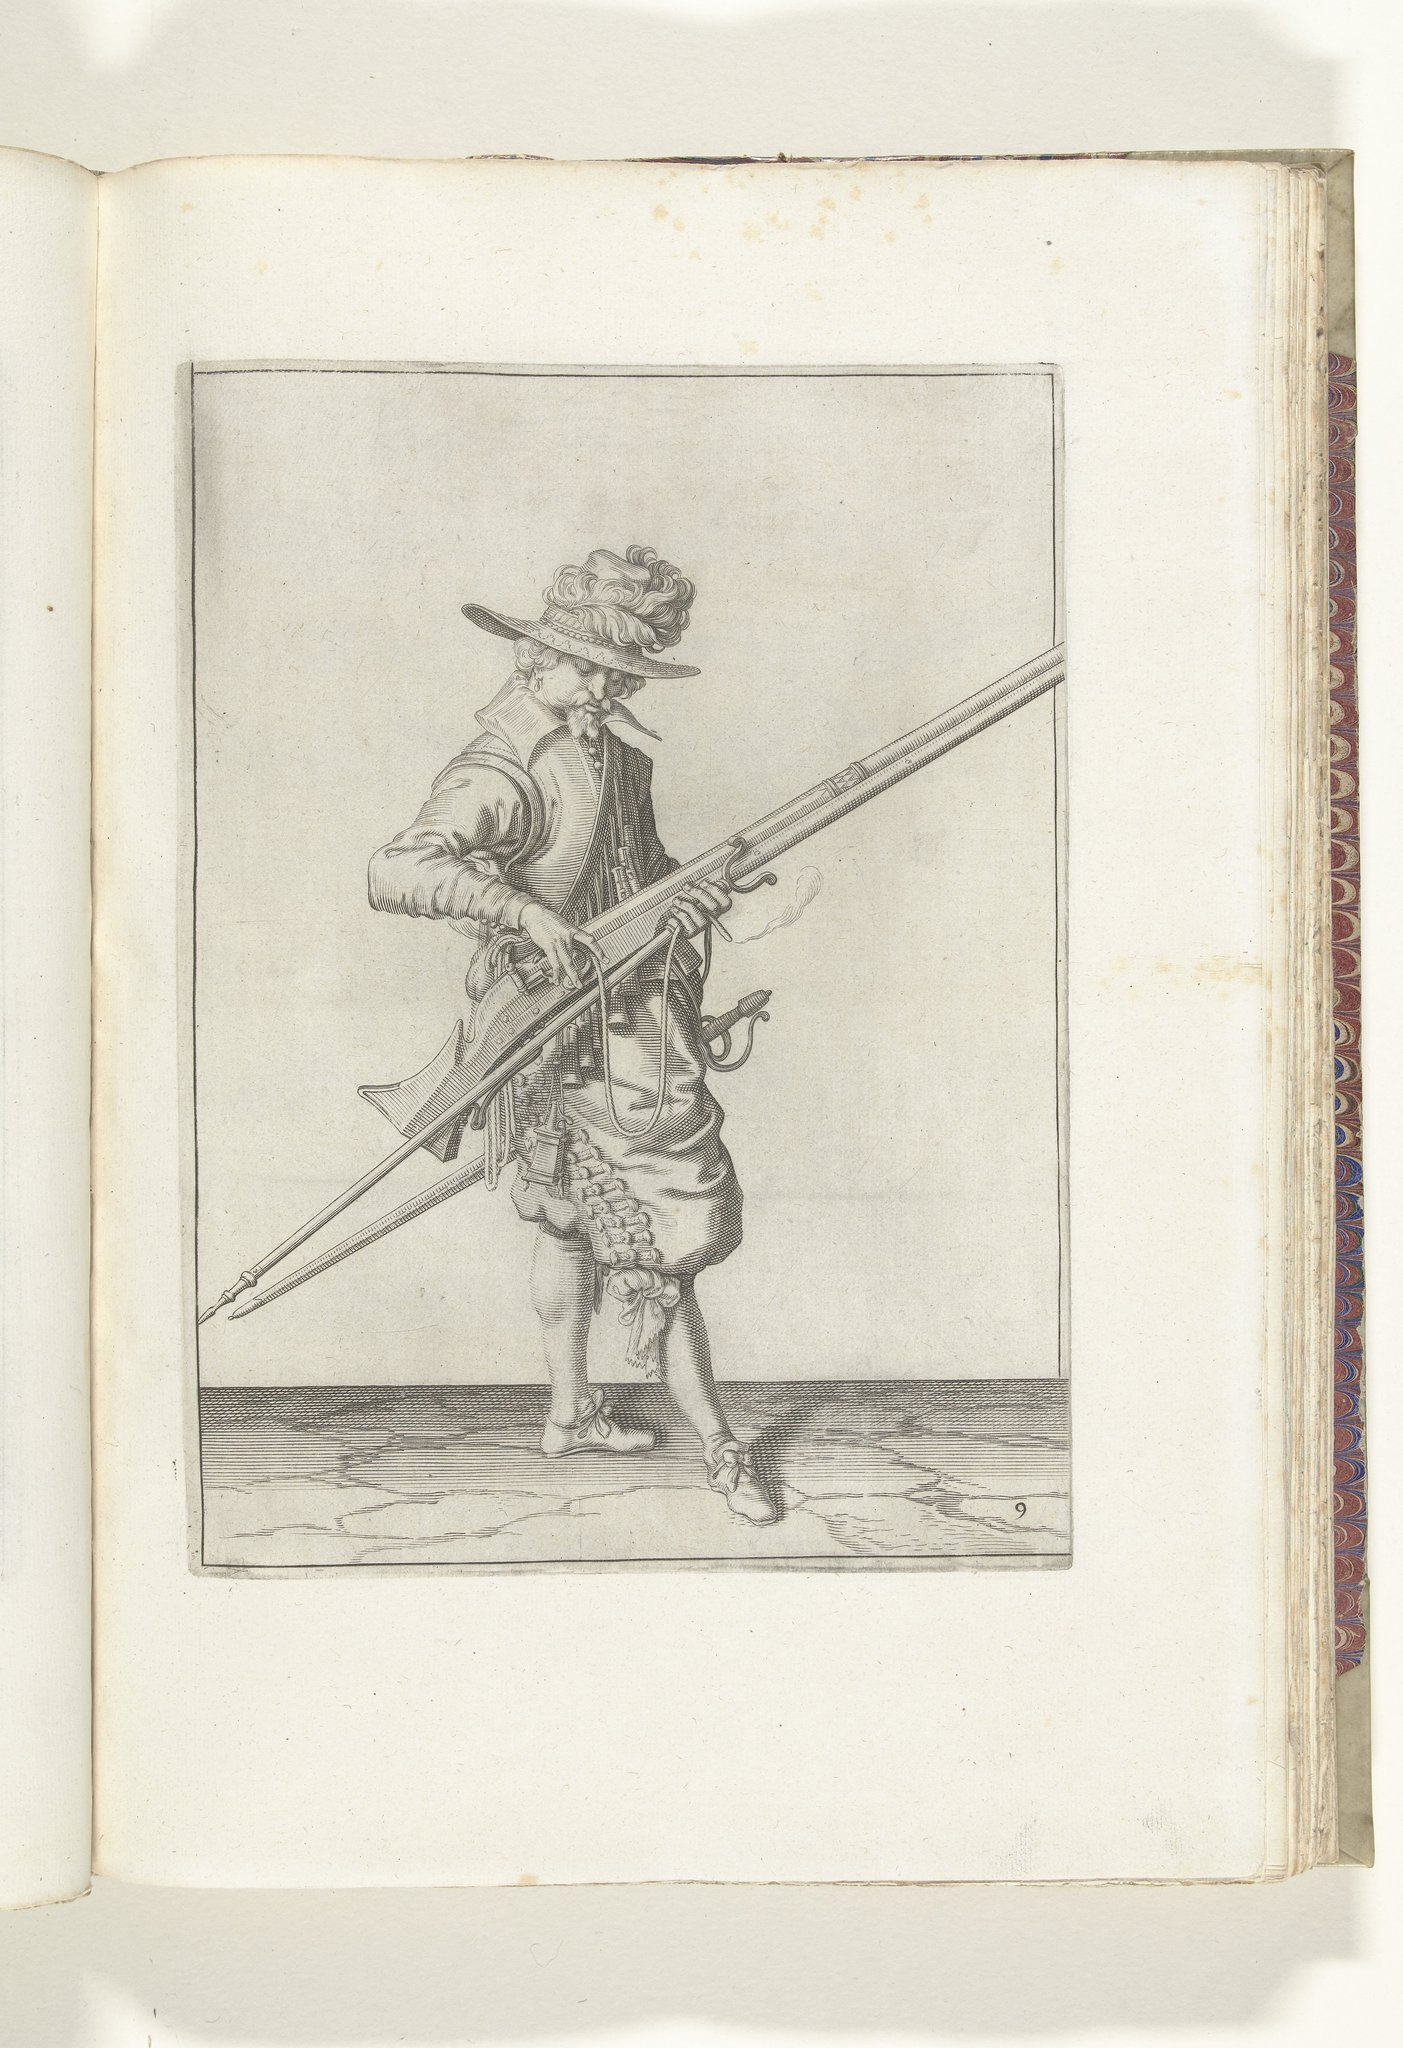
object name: print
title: Soldaat die de lont op de haan van zijn musket de juiste plek en vorm geeft (nr. 9), ca. 1600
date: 1597-1607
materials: paper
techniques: engraving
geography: northern netherlands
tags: the hague, maurice (prince of orange), handling of weapons ~ military training, weapons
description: Een soldaat, ten voeten uit, naar rechts, die een musket (een bepaald type vuurwapen) met zijn linkerhand vasthoudt (nr. 9), ca. 1600. Met duim en middelvinger van zijn rechterhand geeft hij de brandende lont op de haan (onderdeel van het ontstekingsmechanisme) van zijn musket de juiste plek en vorm. Plaat 9 in de instructies voor het hanteren van het musket: Corte onderrechtinghe op de figuerlicke afbeeldinghe, soo veel aengaet het recht ghebruyck van Musquet. Onderdeel van de illustraties in: J. de Gheyn, Wapenhandelinghe van Roers Musquetten ende spiessen, Amsterdam, 1608. Krijgswezen rond 1600.